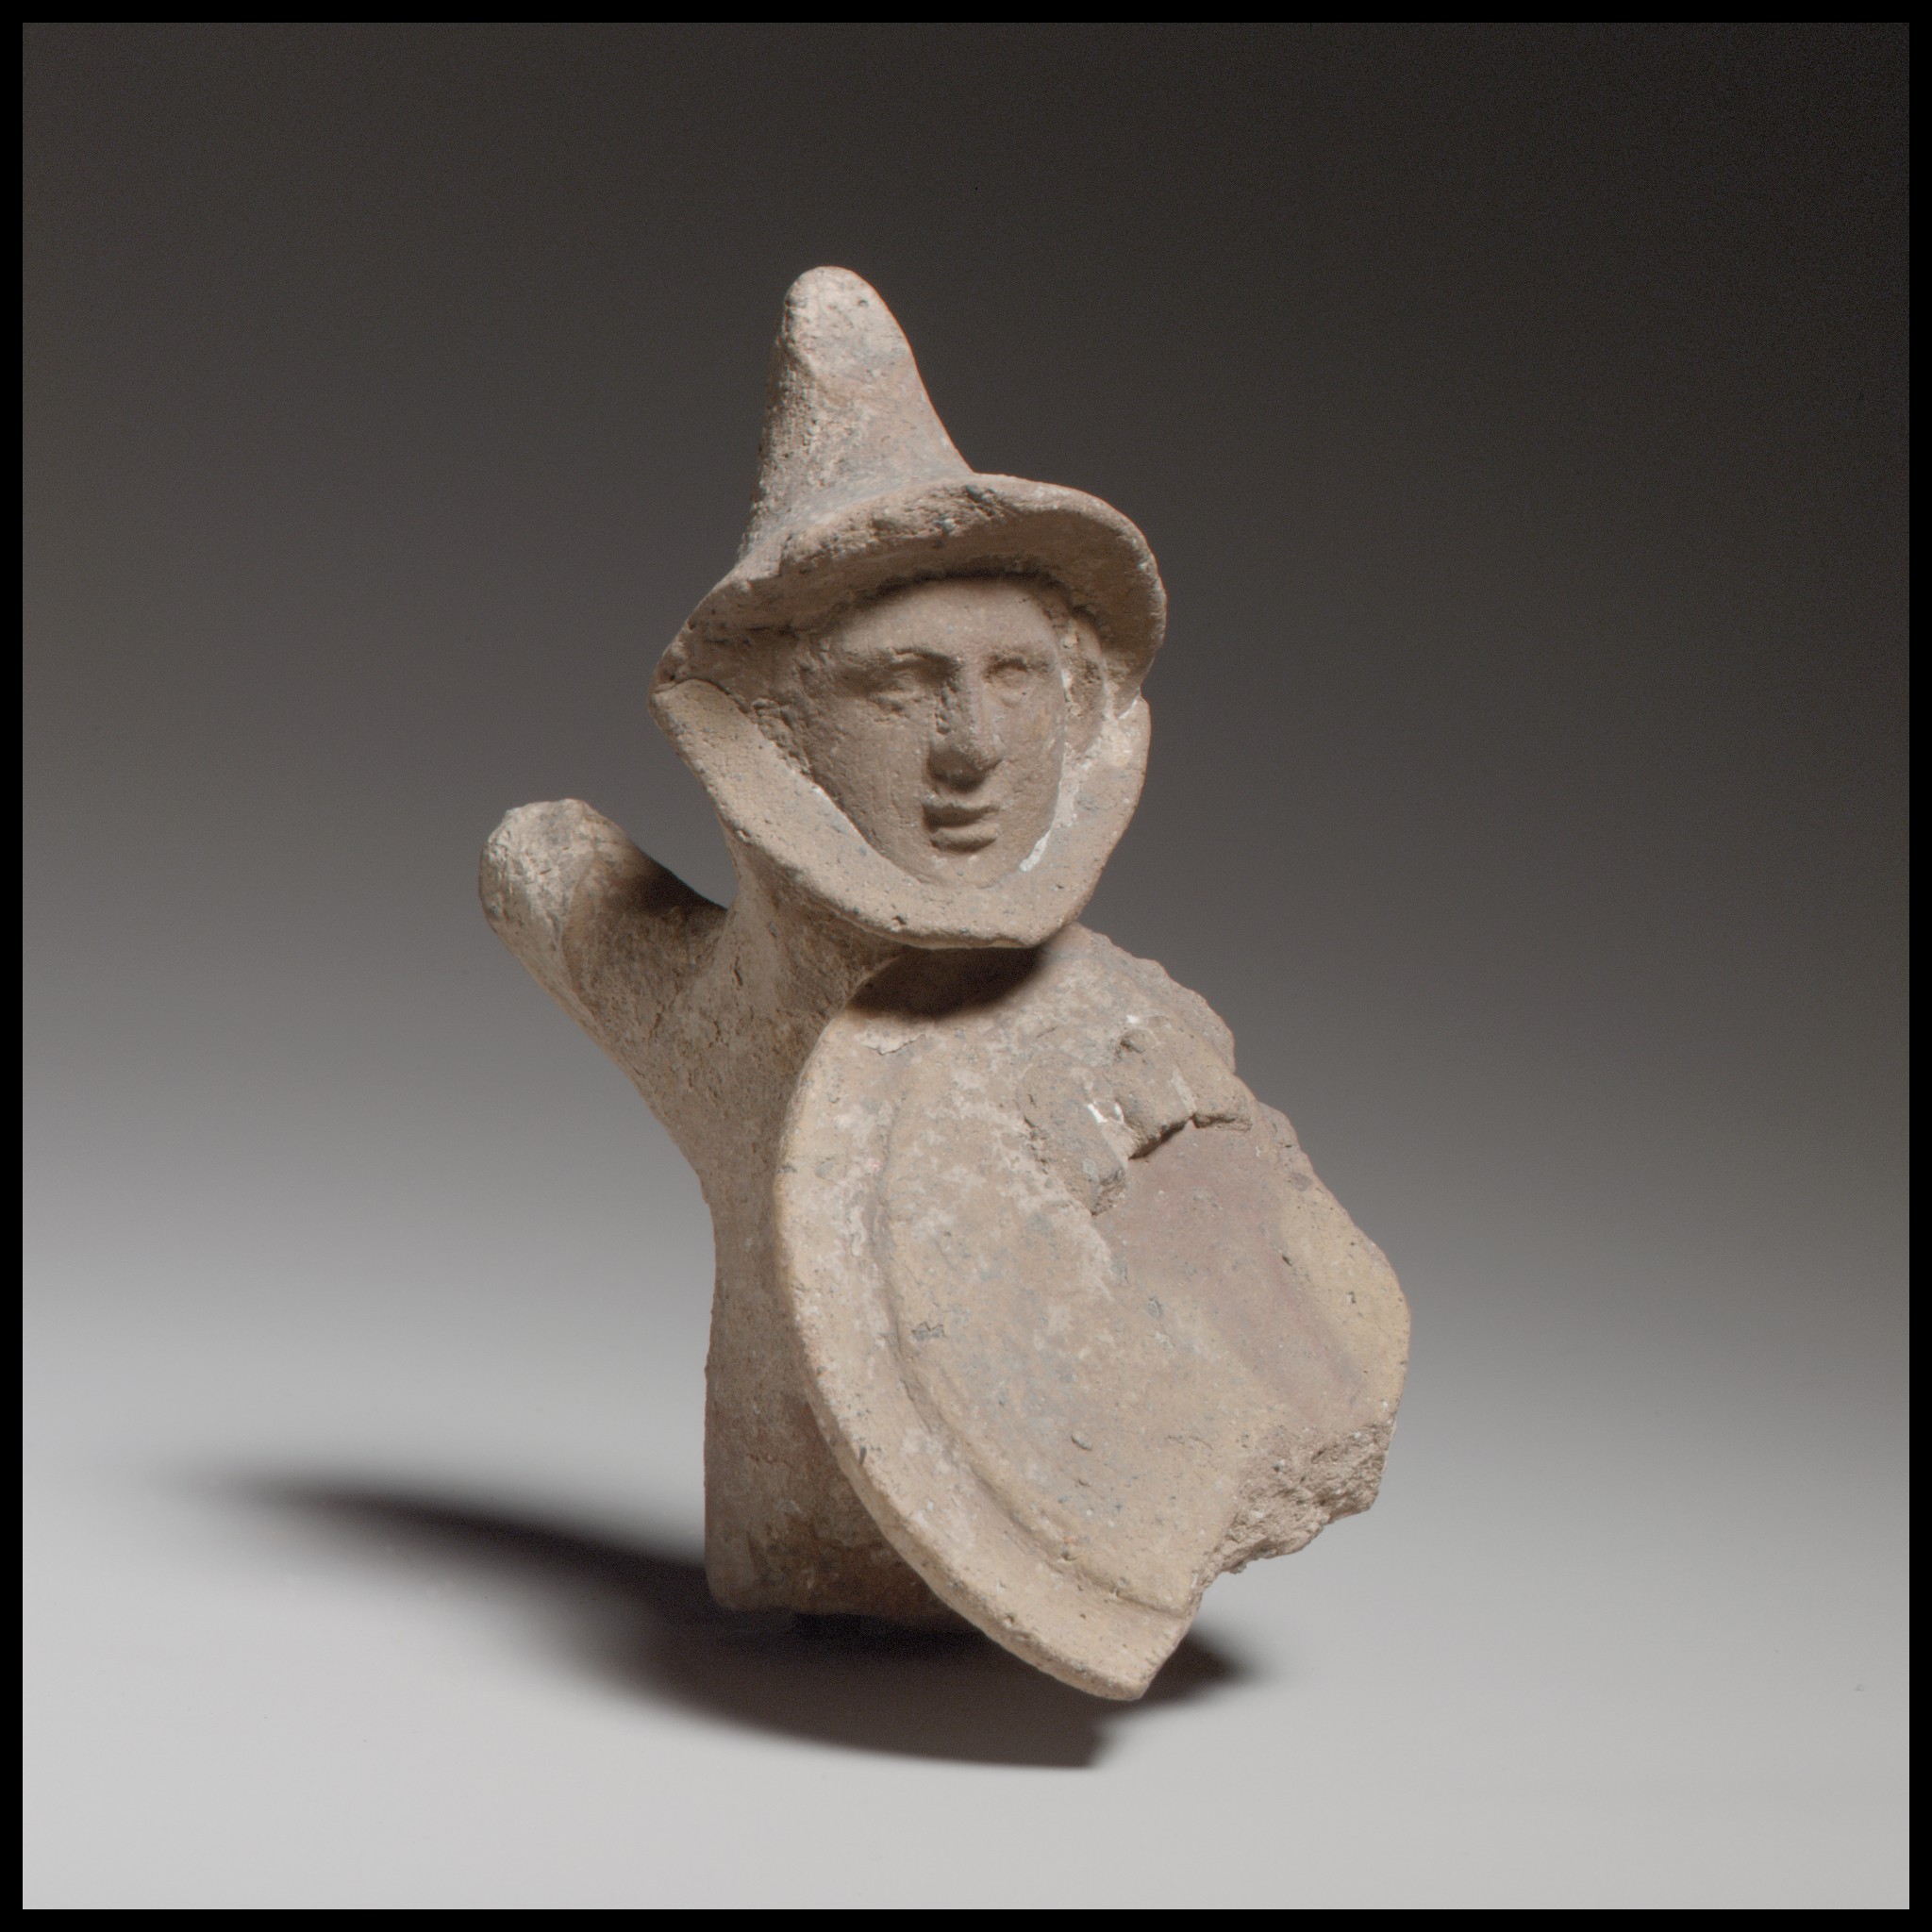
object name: statue of a warrior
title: Horseman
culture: cypriot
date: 334-301 BCE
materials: terracotta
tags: shields,men